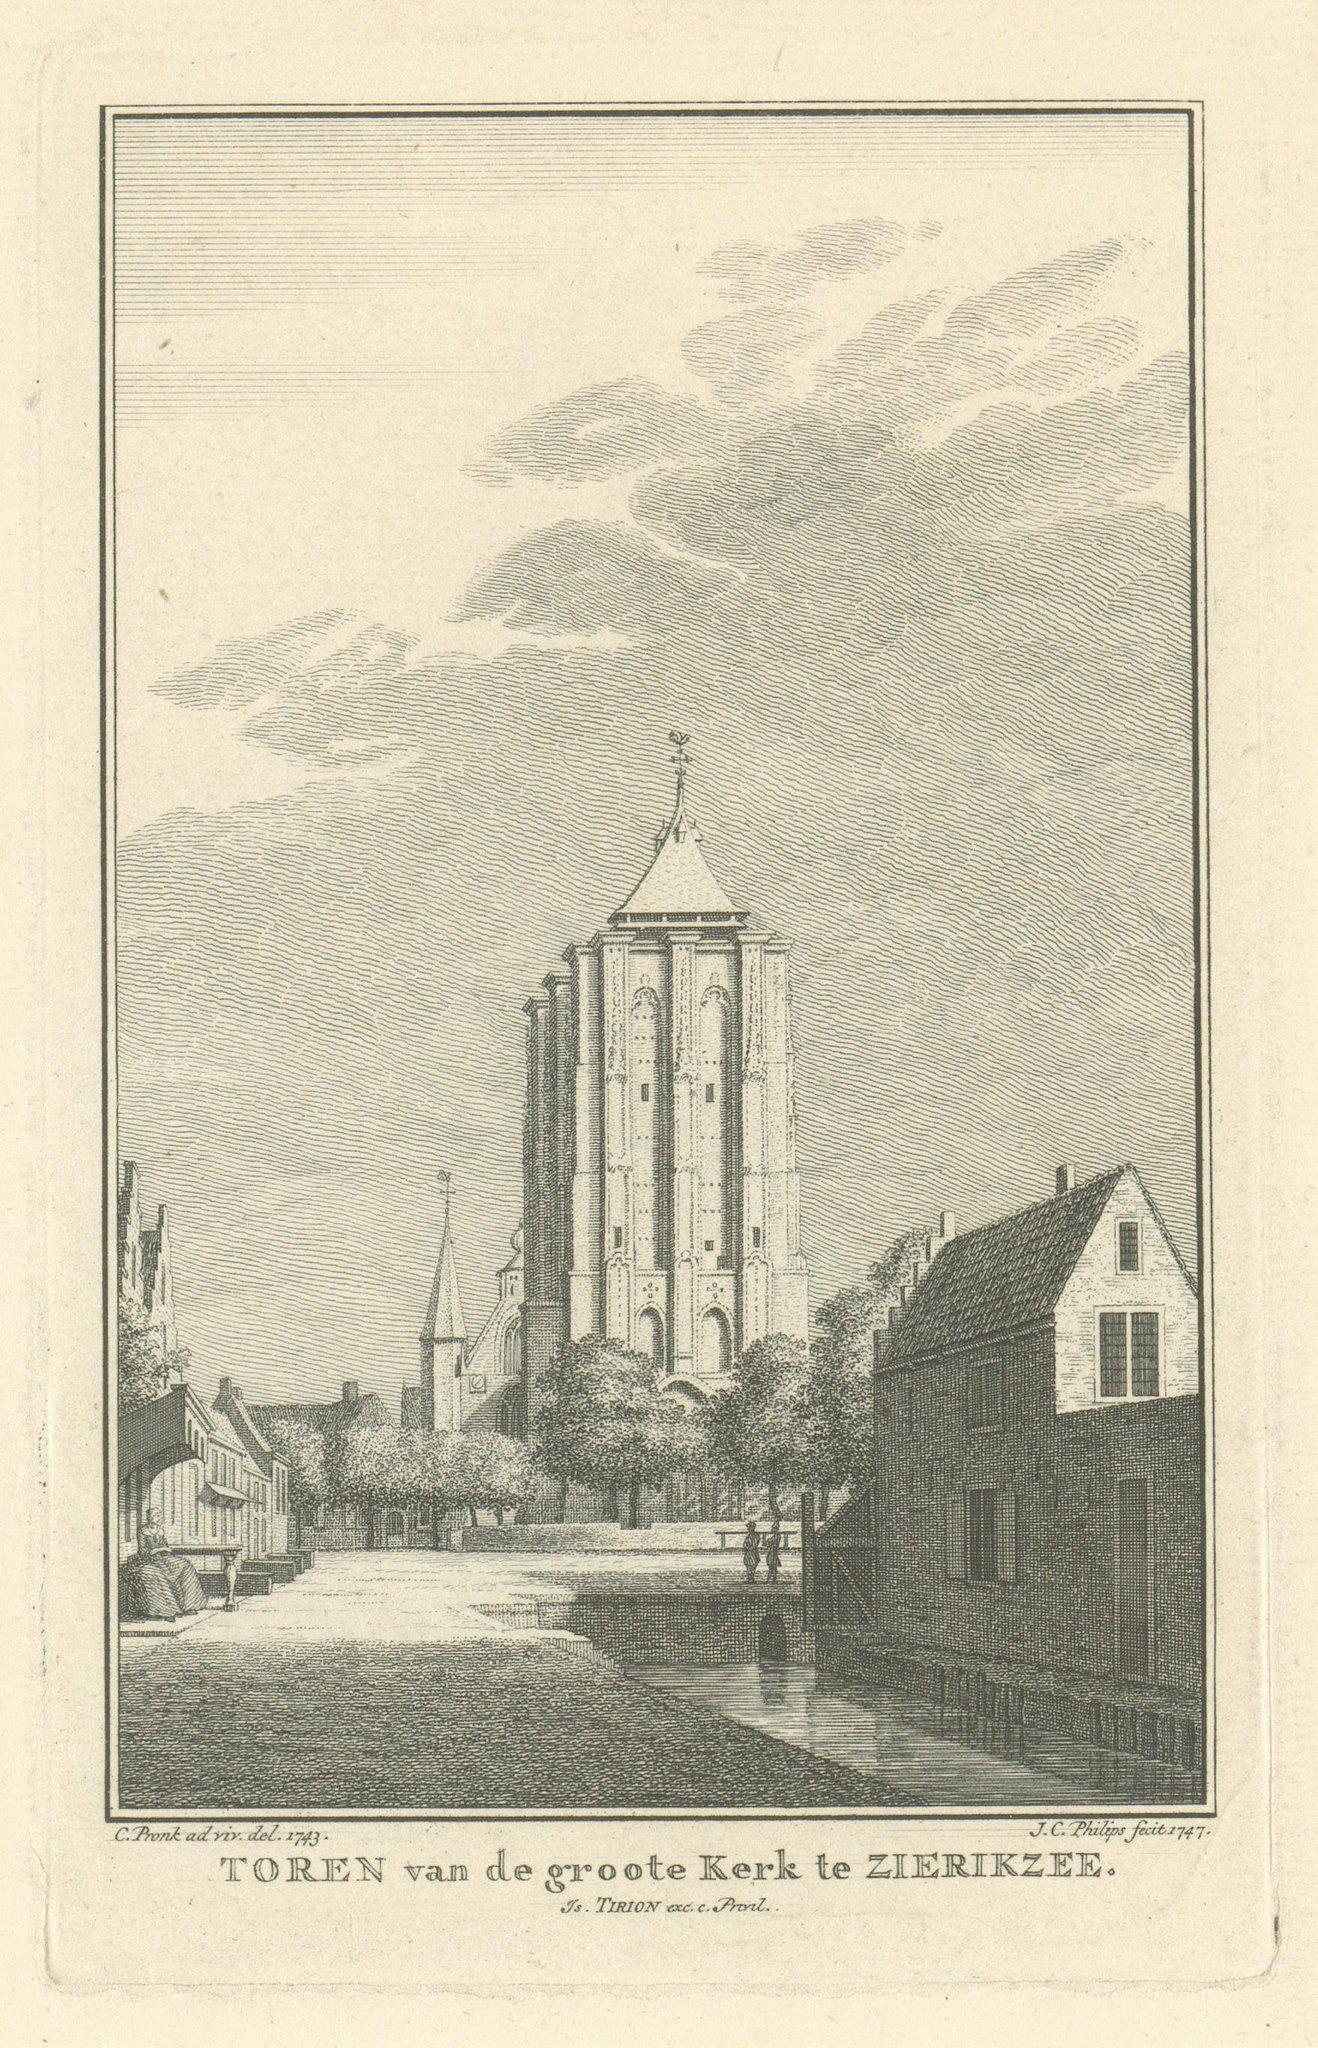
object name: print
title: Gezicht op de Sint-Lievensmonstertoren te Zierikzee, 1743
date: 1747-1760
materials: paper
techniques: engraving, etching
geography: amsterdam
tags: church (exterior), parts of church exterior and annexes: tower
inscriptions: collector's mark: Lugt 2228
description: Gezicht op de toren van de Sint-Lievensmonsterkerk te Zierikzee, in de situatie omstreeks 1743.